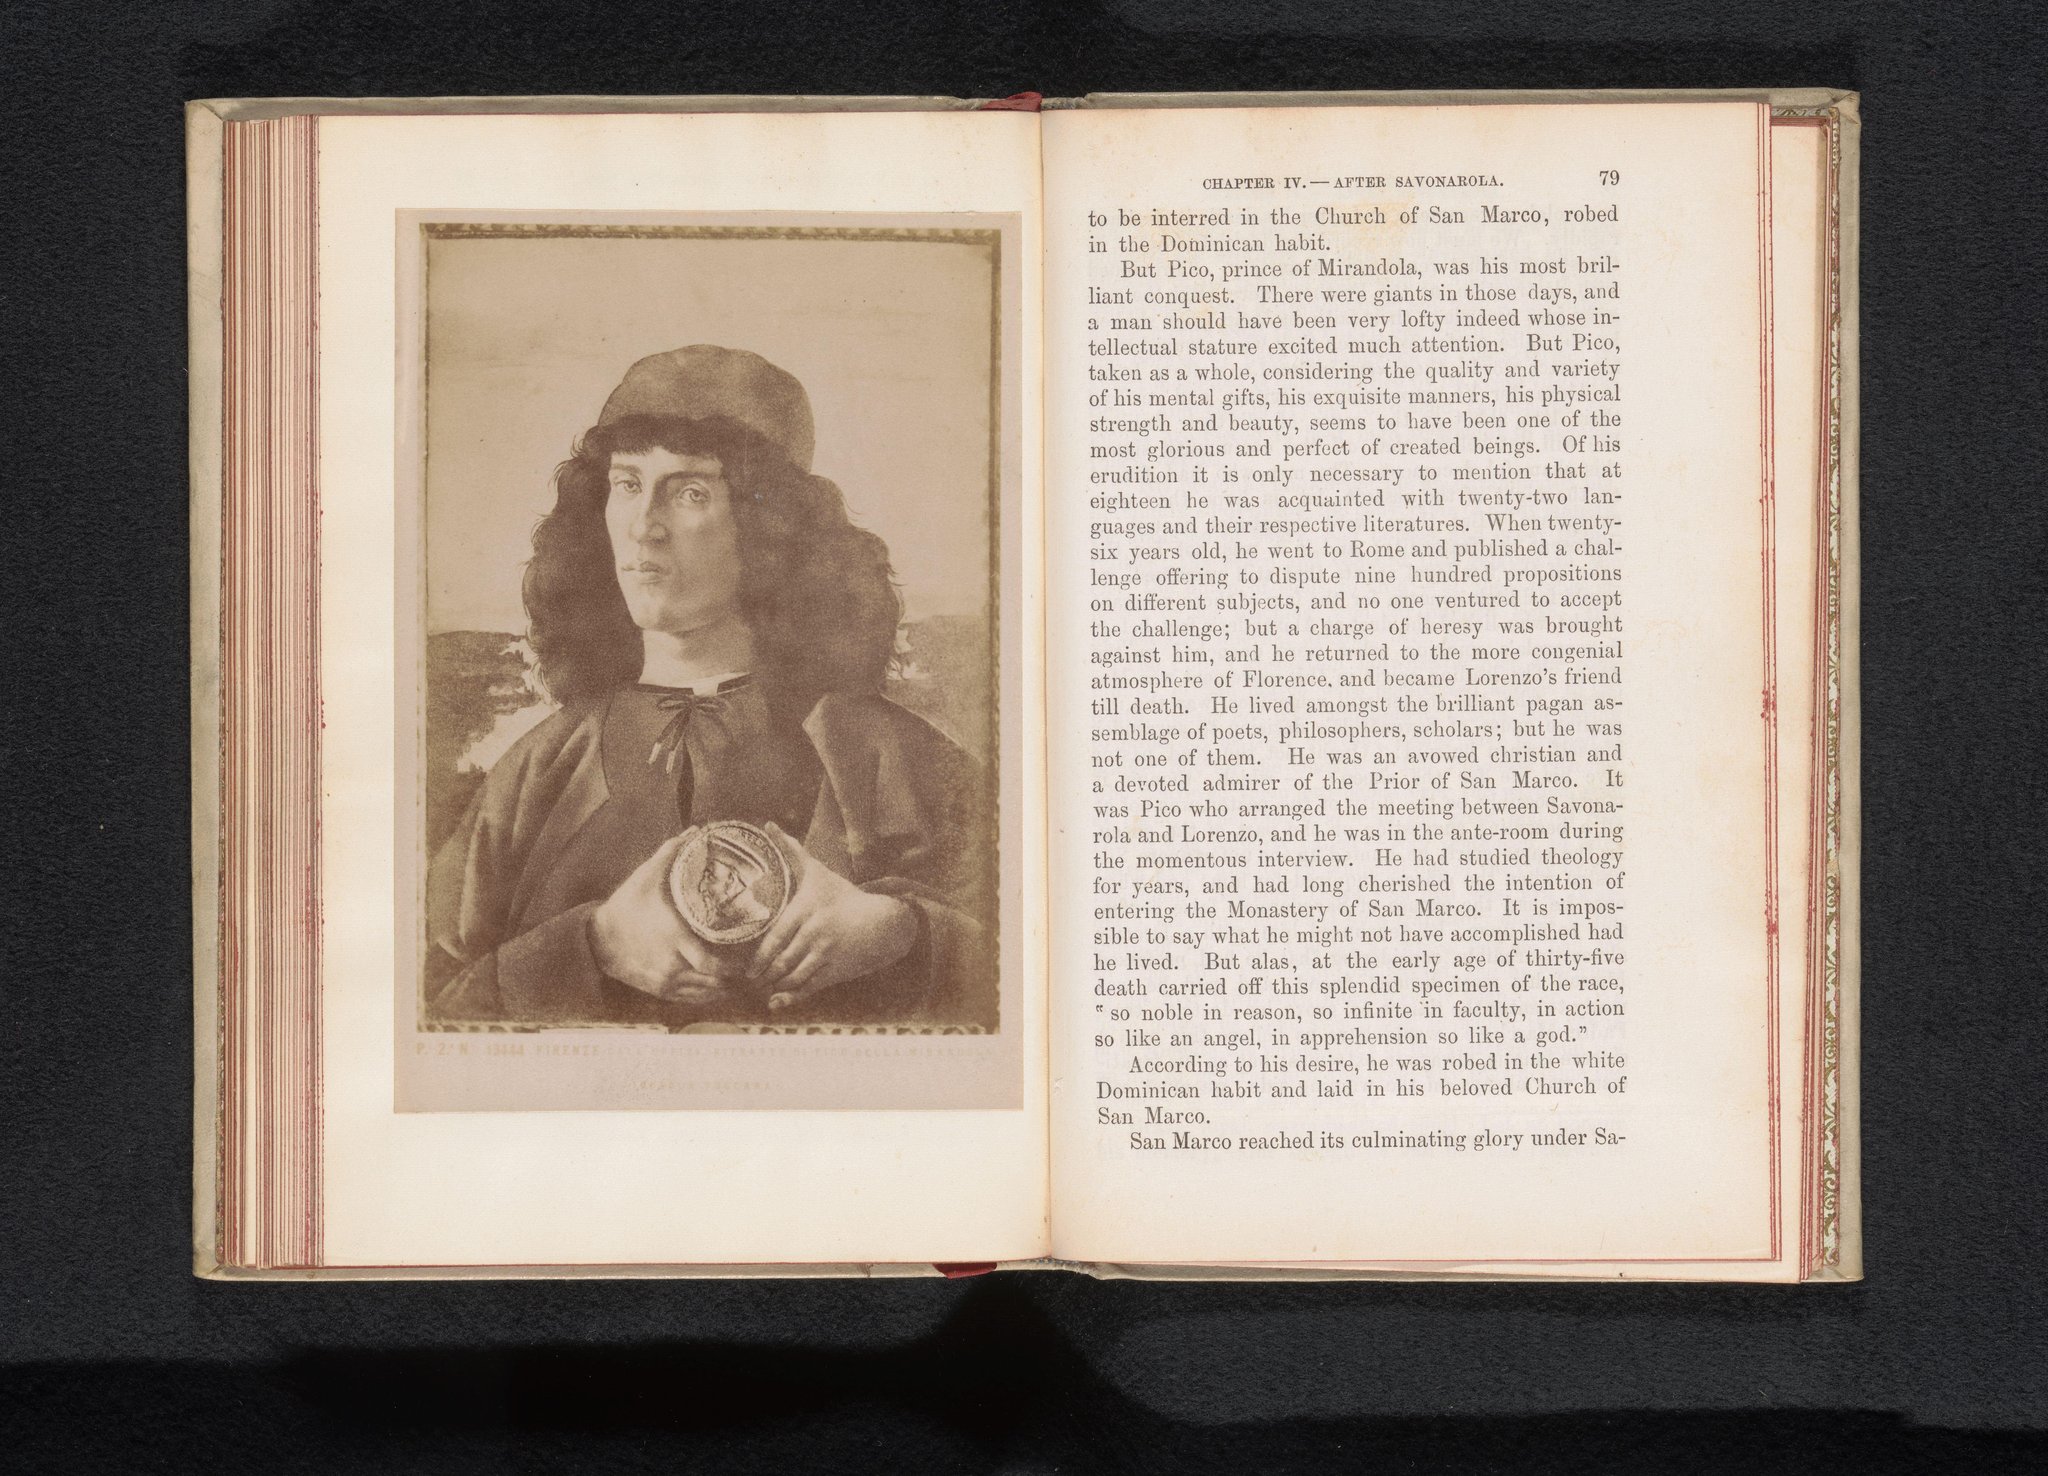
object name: page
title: Firenze- Gal. Uffizi ritratto di Pico della Mirandola [(...)]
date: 1878-1888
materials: photographic support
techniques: albumen print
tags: portrait of a writer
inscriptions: number: ‘Pi 2a no. 13444’